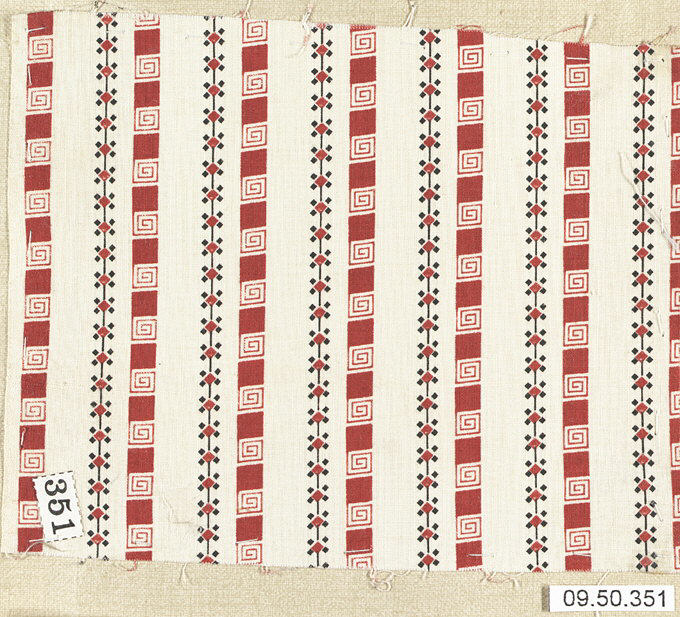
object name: piece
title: Piece (one of 116)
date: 1801-1900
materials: cotton